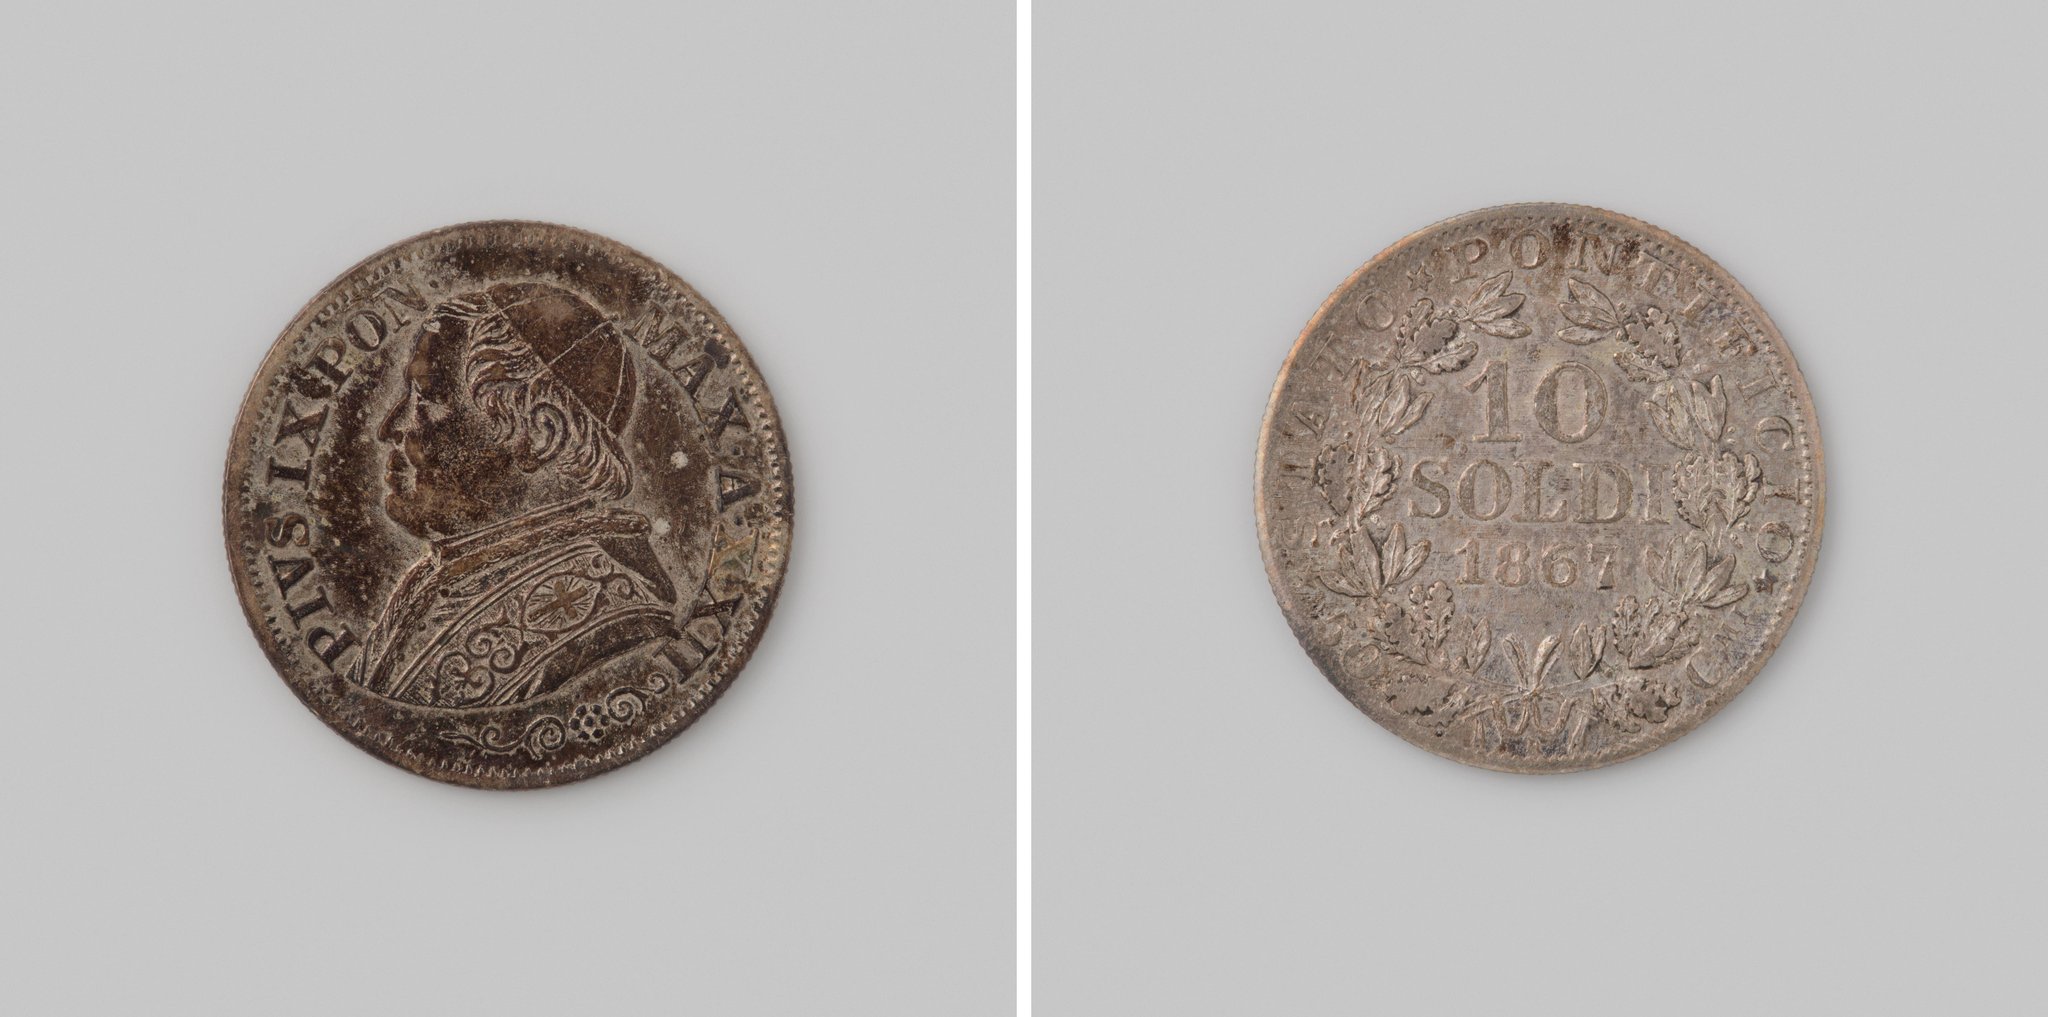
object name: coin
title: 10 soldi uit de Kerkelijke Staat van paus Pius IX, 1867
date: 1867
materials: silver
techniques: striking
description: Zilveren munt. Voorzijde: portret van de paus naar links. In omschrift jaartal: An XXII = 1867. Keerzijde: binnen twee samengebonden takken waarde-aanduiding in twee regels, waaronder jaartal. Onderaan letter R. Kartelrand.